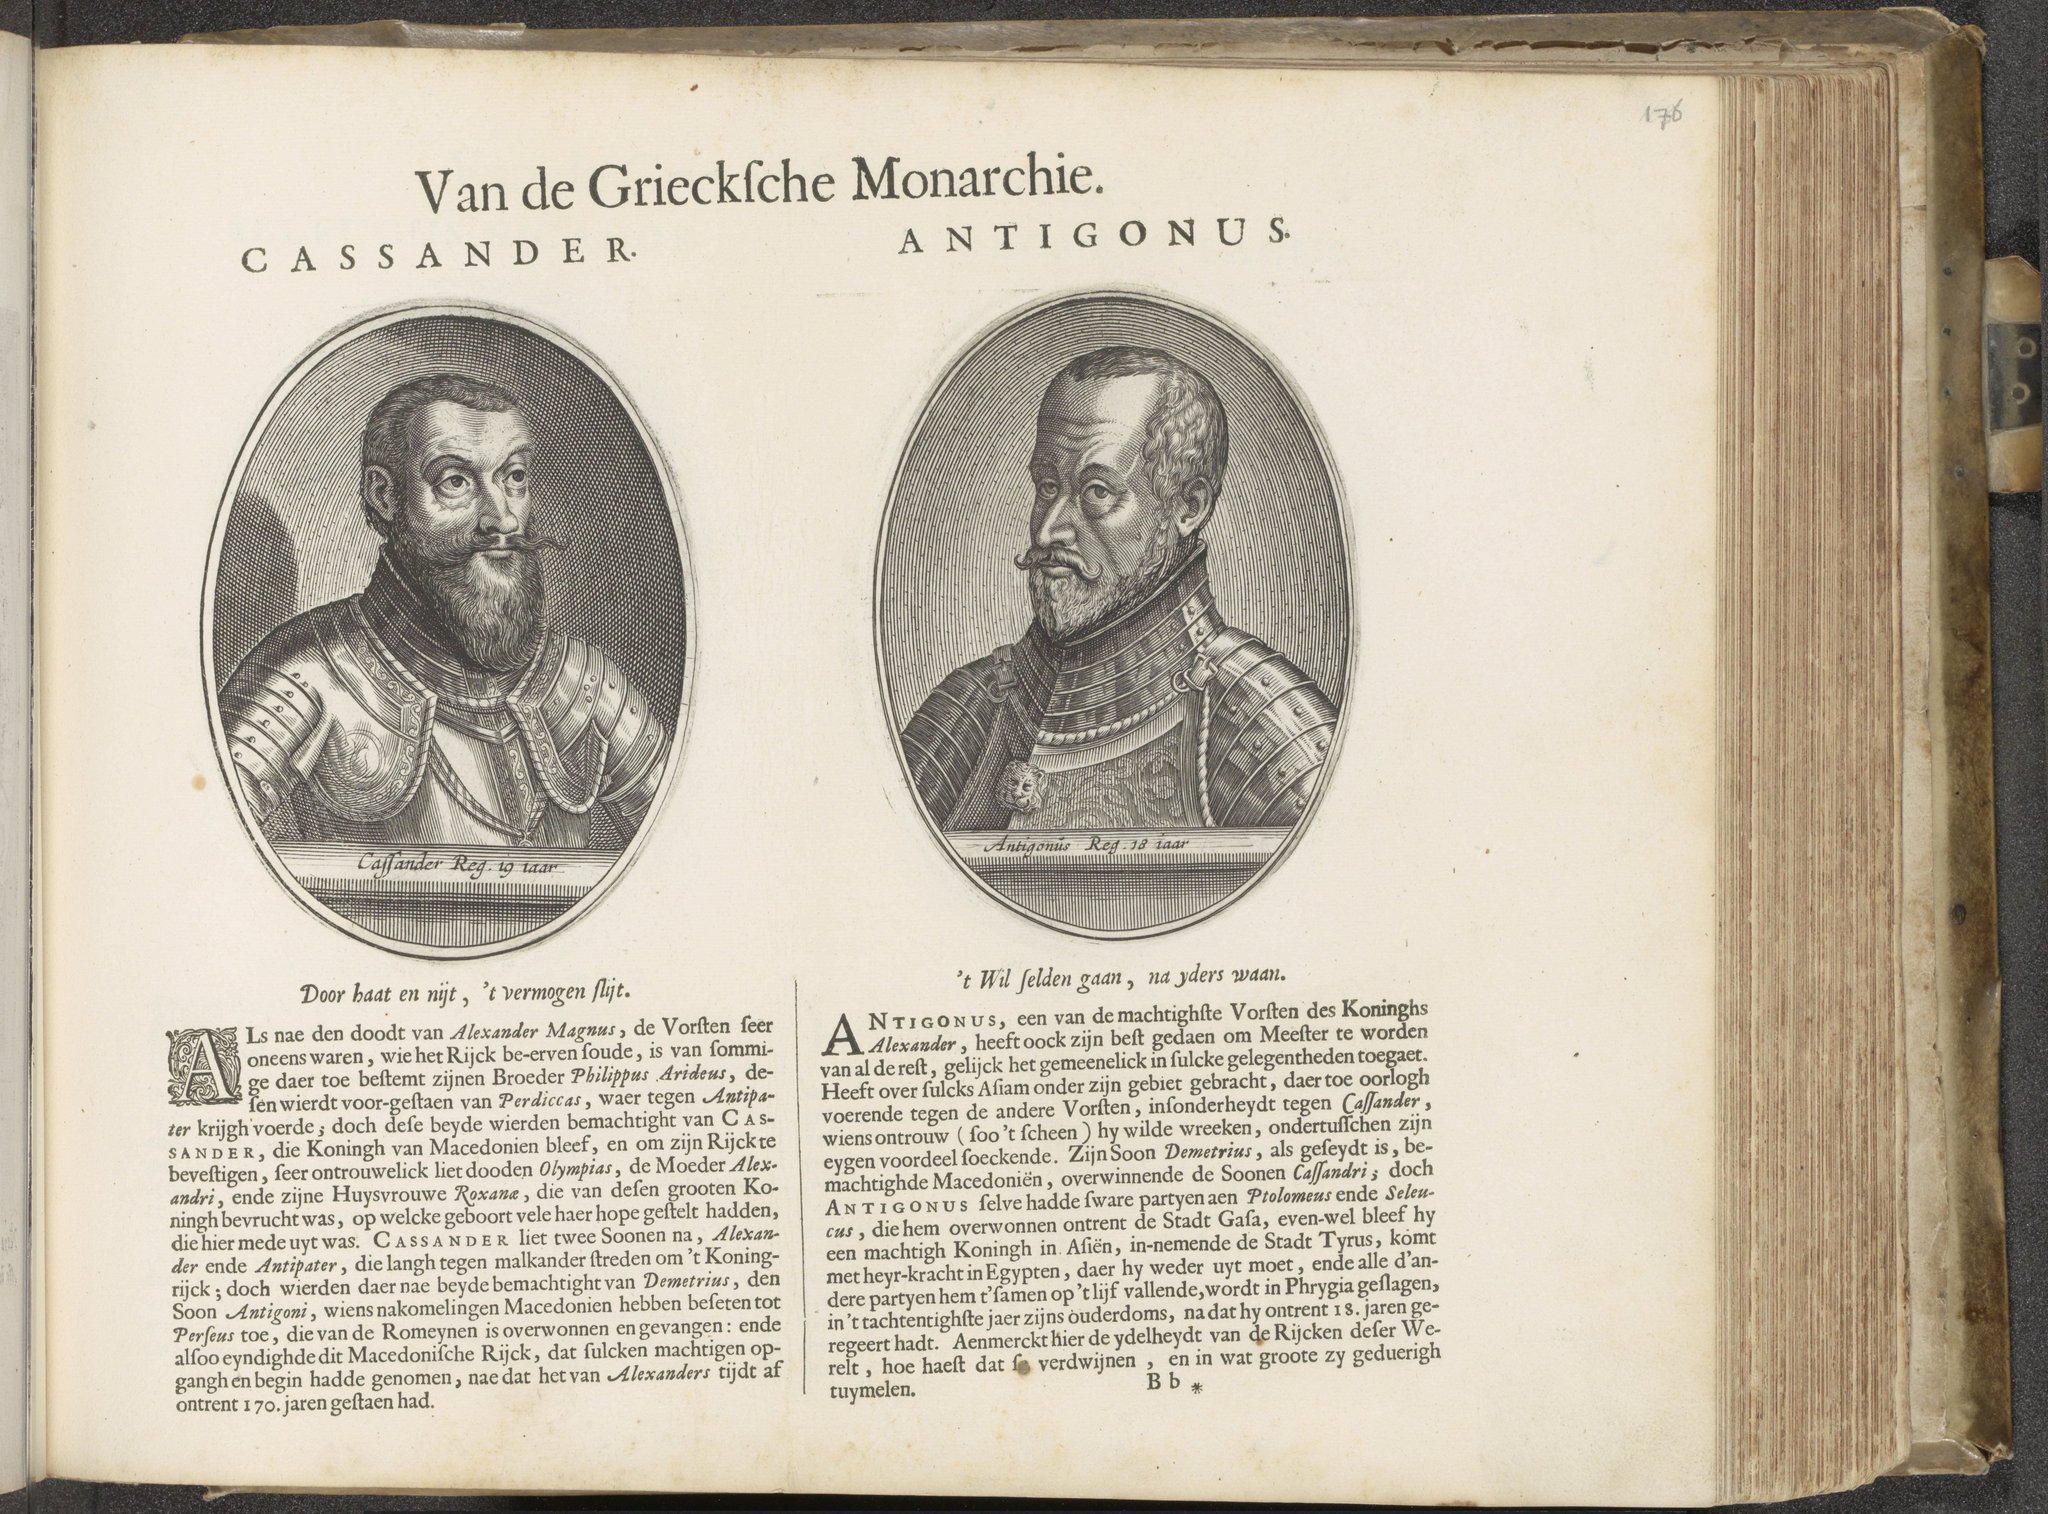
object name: album leaf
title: Den Grooten Emblemata Sacra, bestaande in meer dan vier hondert bybelsche figuren, zoo des Ouden als des Nieuwen Testaments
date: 1610-1625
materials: paper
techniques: engraving, letterpress printing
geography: amsterdam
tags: frederik ii (koning van denemarken en noorwegen), politician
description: Portretten van Lazarus von Schwendi en Frederik II van Denemarken en Noorwegen, in dit album gebruikt als afbeeldingen van respectievelijk Kassander en Antigonos I, koningen van het Macedonische Rijk. De begeleidende tekst begint met een kleine gedecoreerde initiaal A. Het blad maakt deel uit van een album.